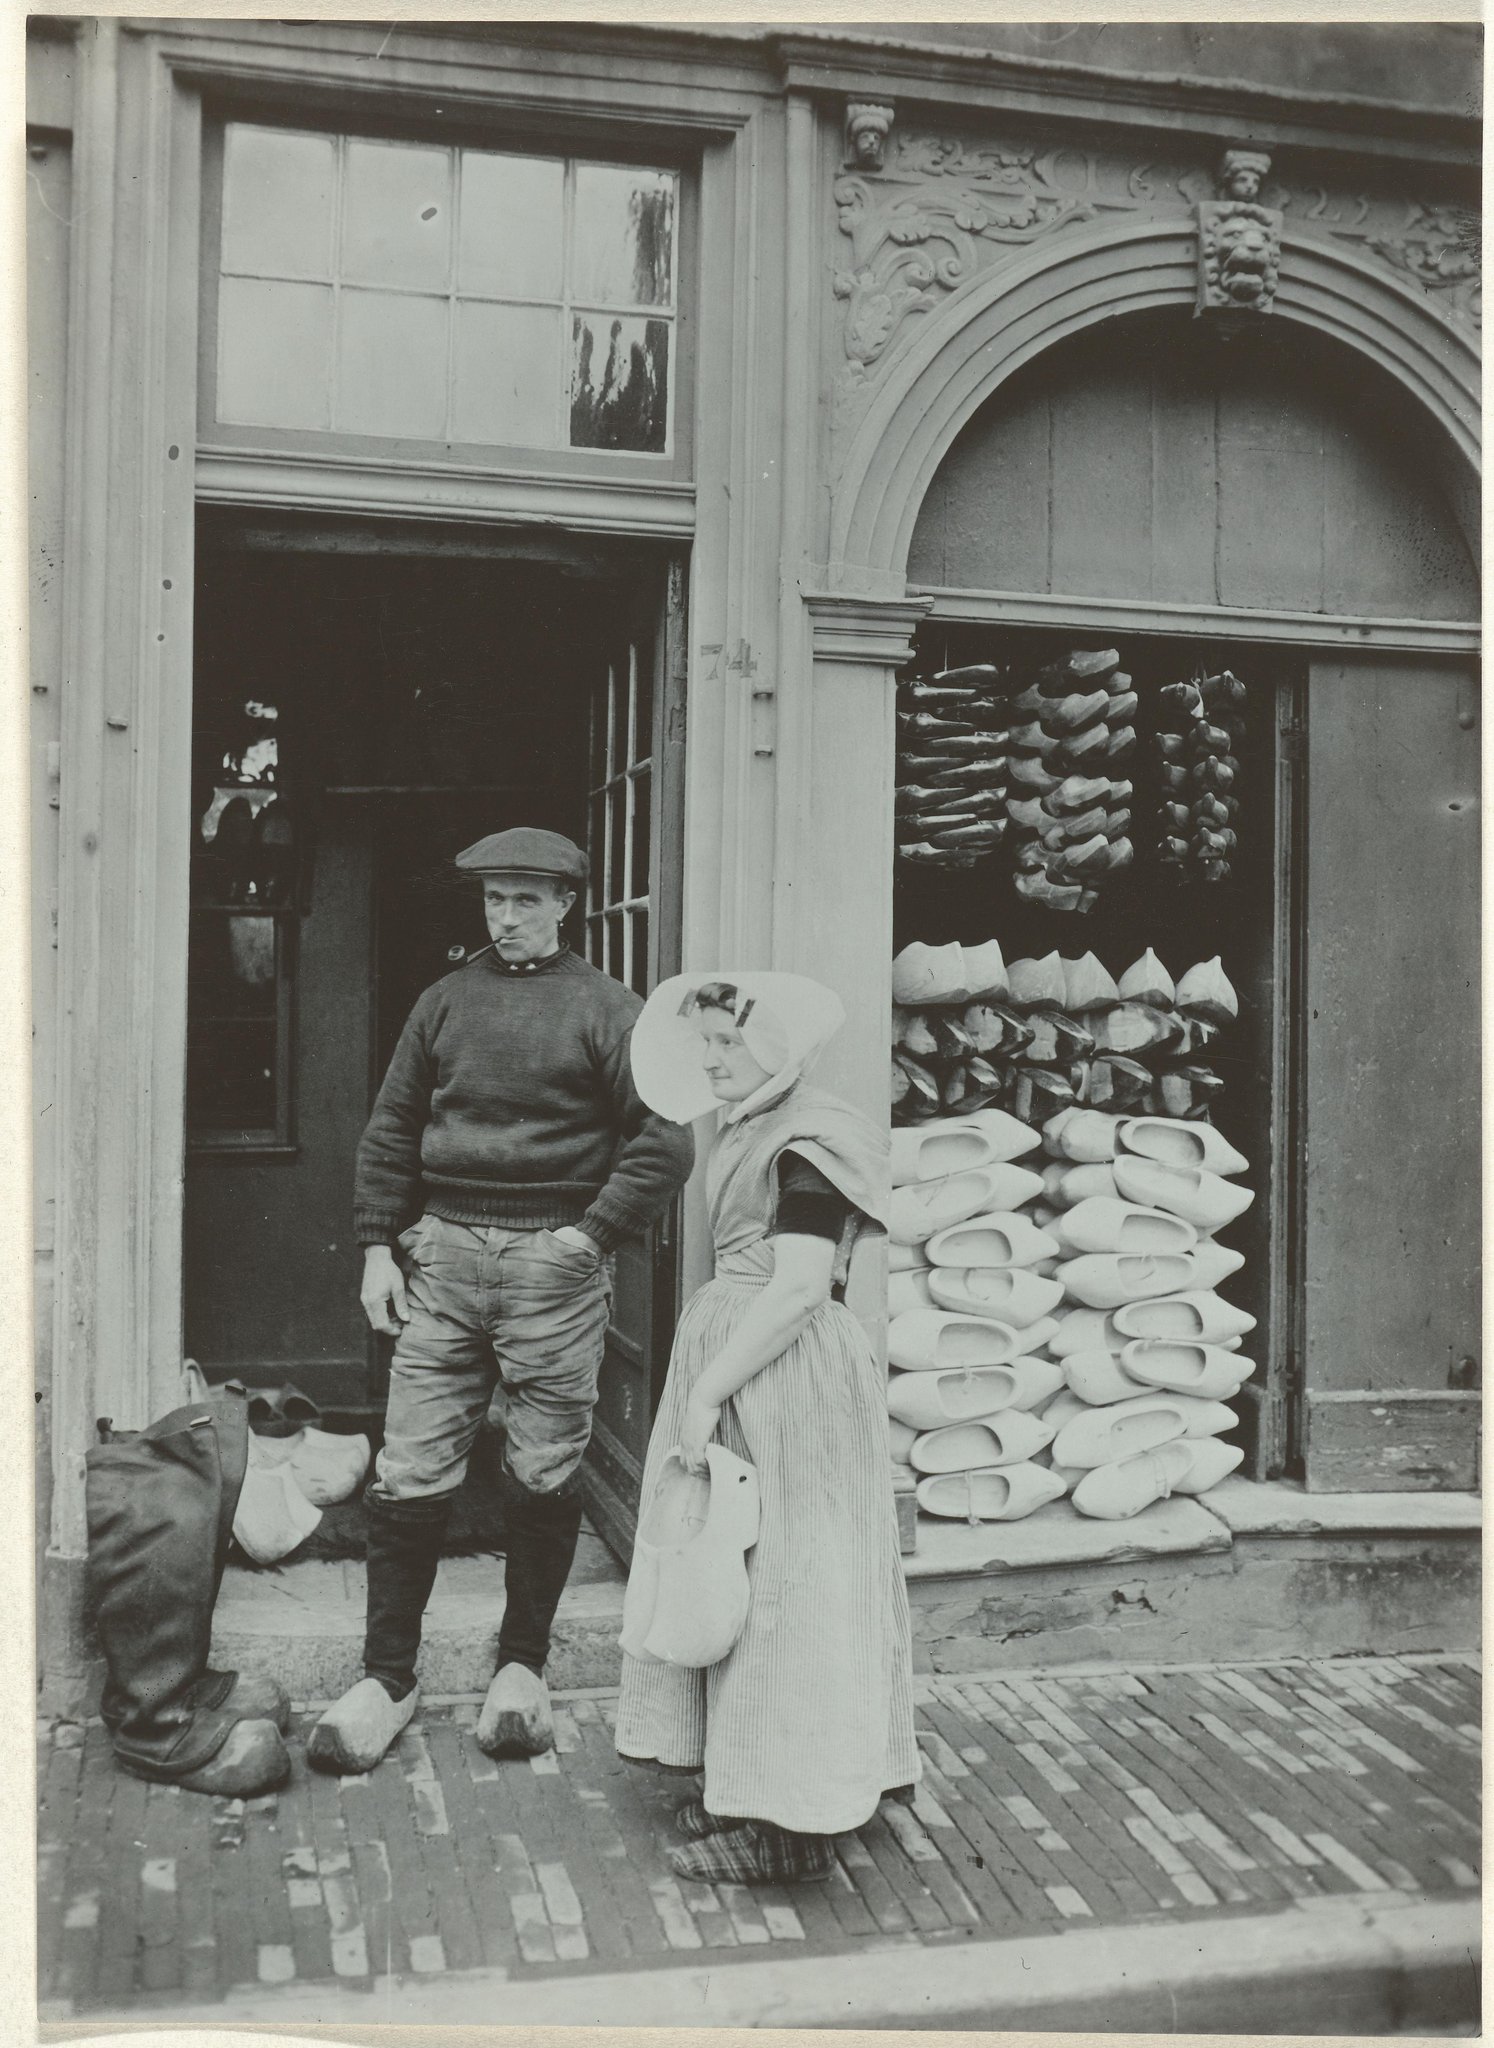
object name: photograph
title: Man en vrouw in Zeeuwse klederdracht voor een klompenwinkel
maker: Anonymous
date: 1930-1960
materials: photographic support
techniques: gelatin silver print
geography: flushing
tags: wooden shoes, clogs, folk costume, regional costume